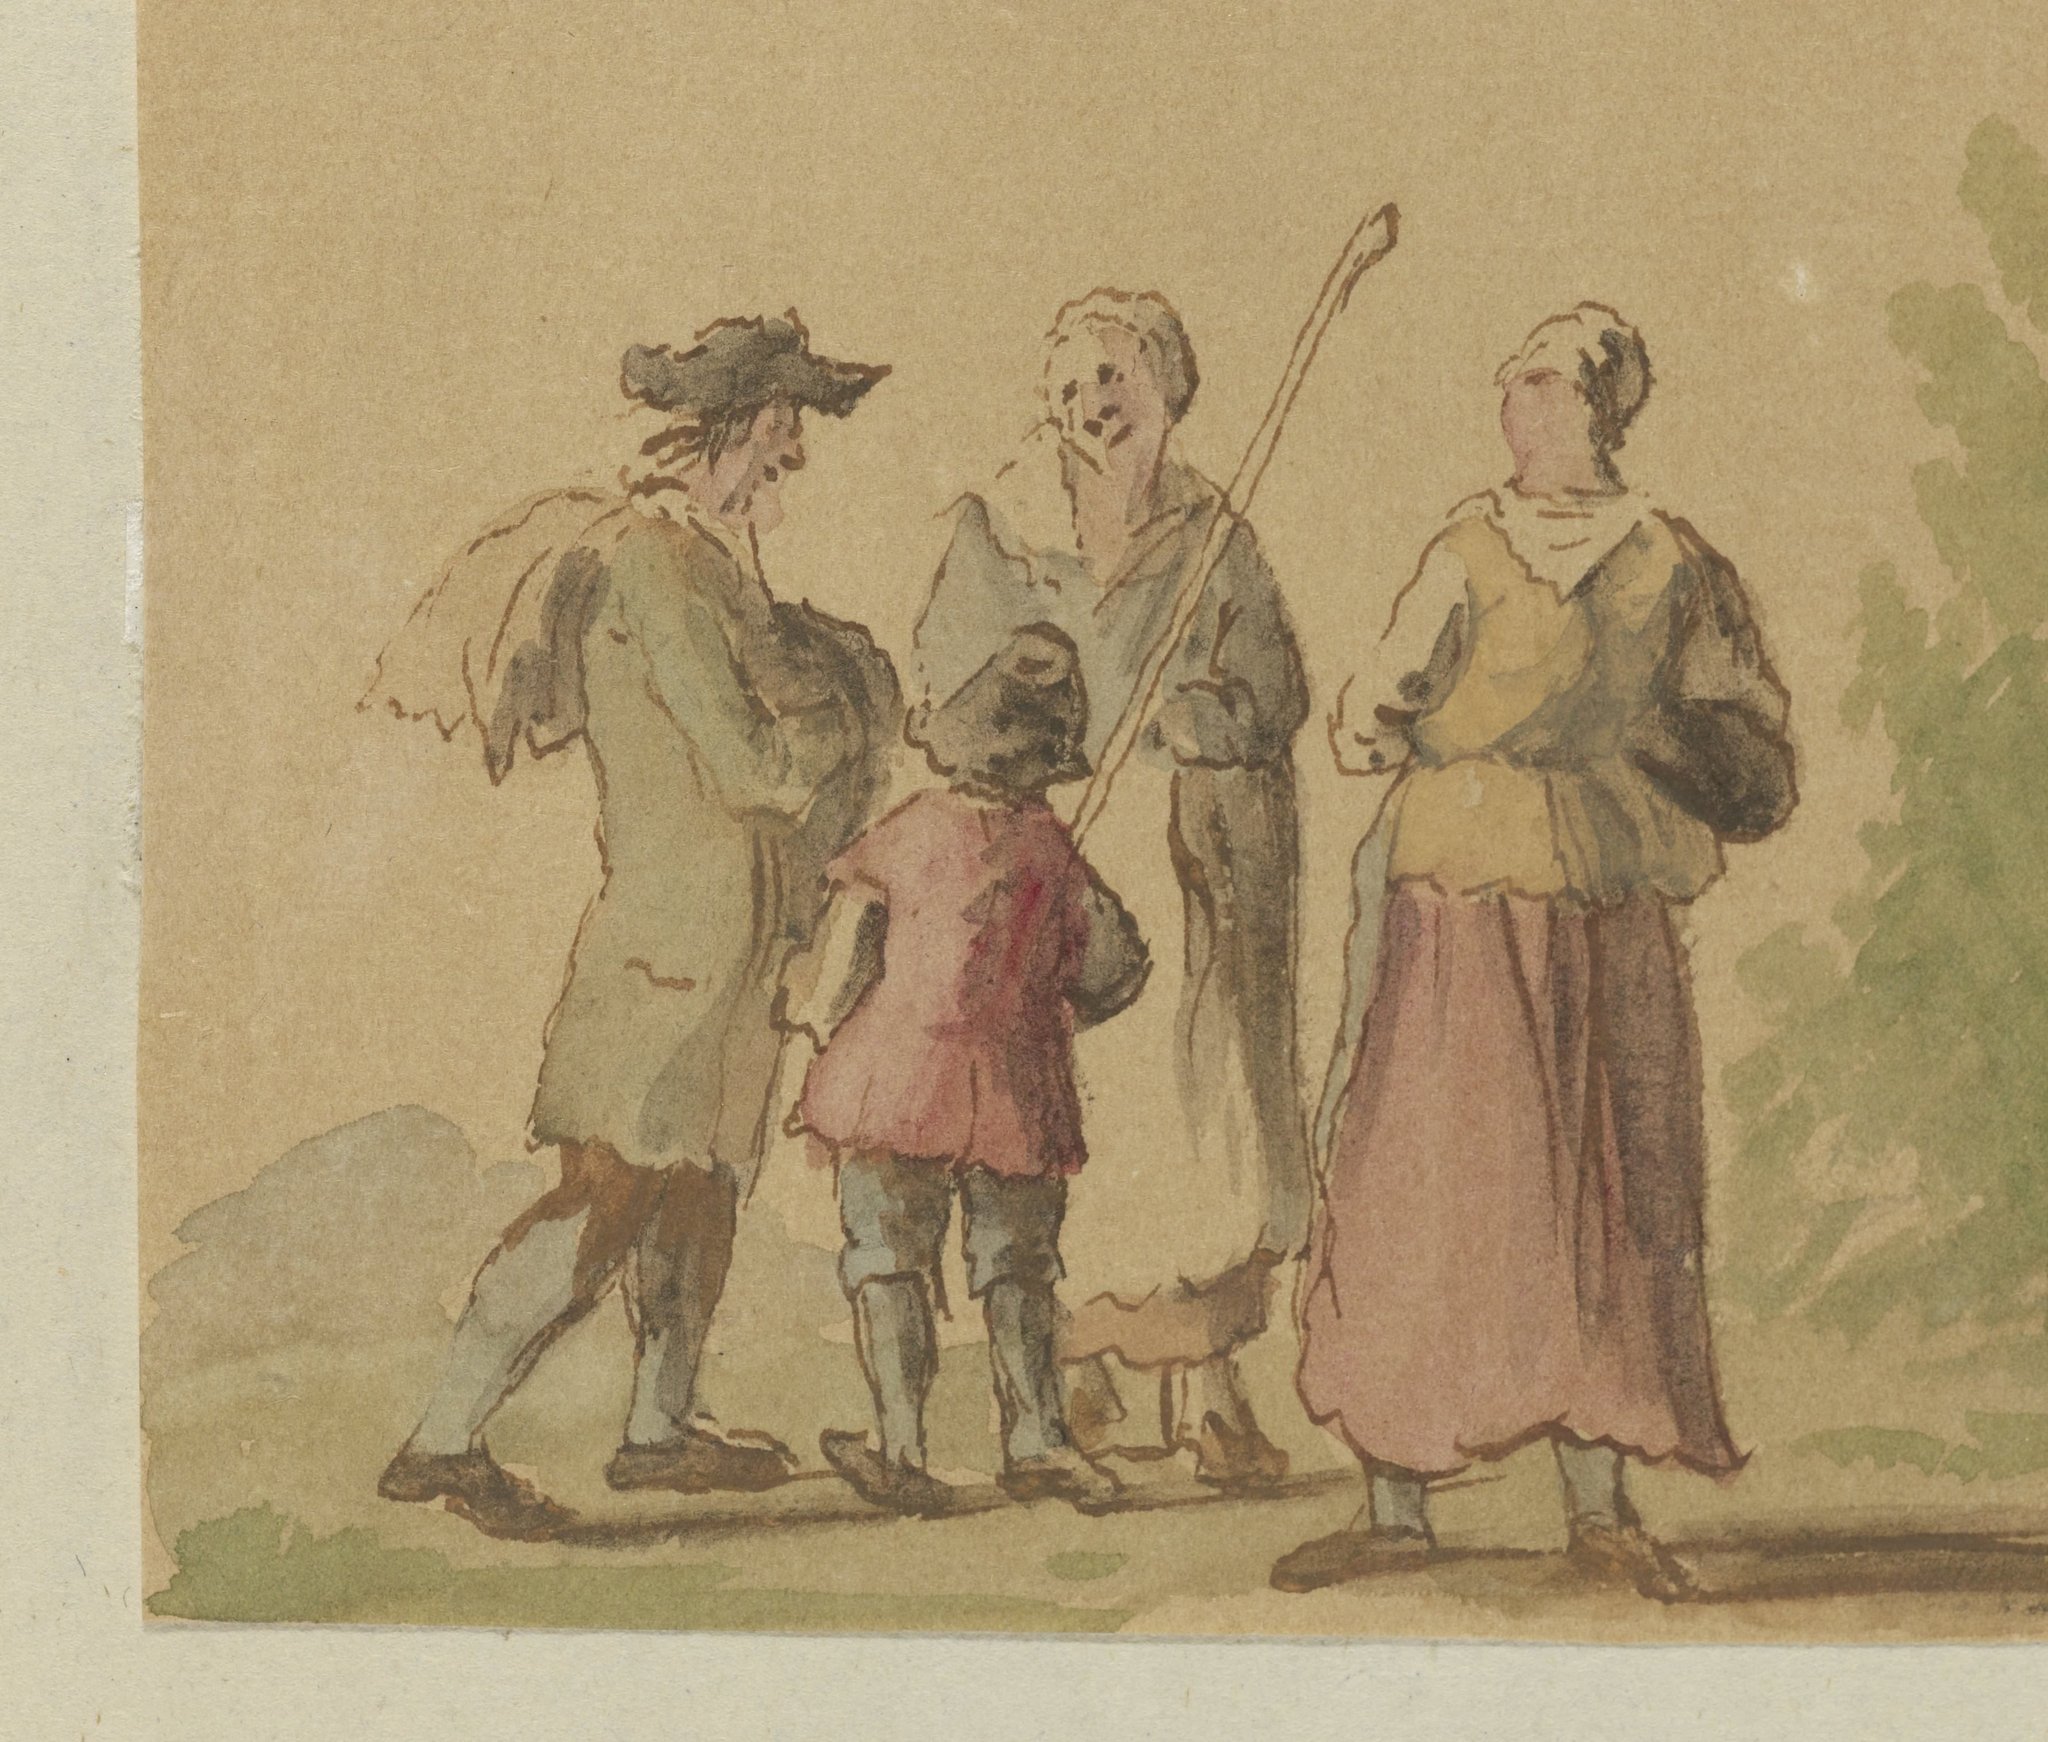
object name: drawing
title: Een man, twee vrouwen en een kind staand in een landschap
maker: Anonymous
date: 1700-1799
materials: ink, paper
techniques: brush, pen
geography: netherlands